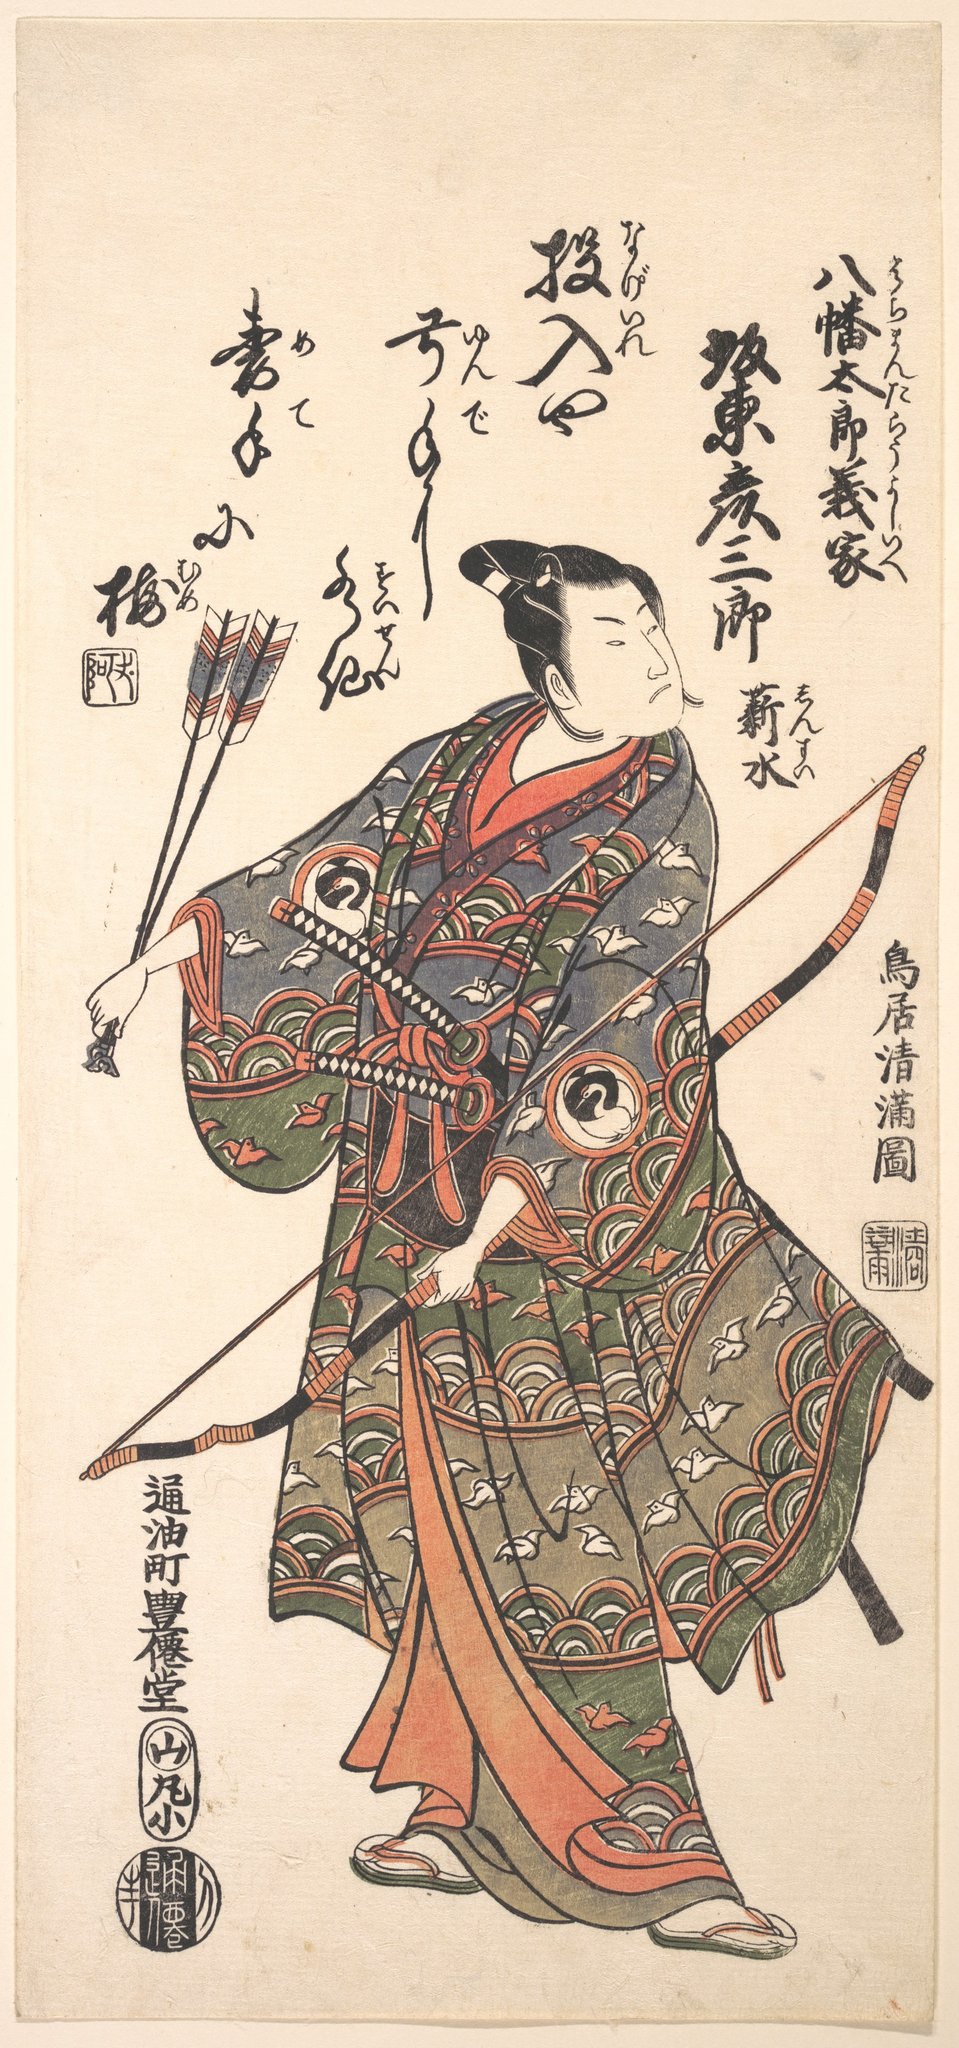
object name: print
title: The Actor Bando Hikosaburo II Holding a Bow and Arrows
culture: japanese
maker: torii kiyomitsu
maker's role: artist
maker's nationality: japanese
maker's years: 1735-1785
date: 1766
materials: ink, paper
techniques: woodblock print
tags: bow and arrow,actors